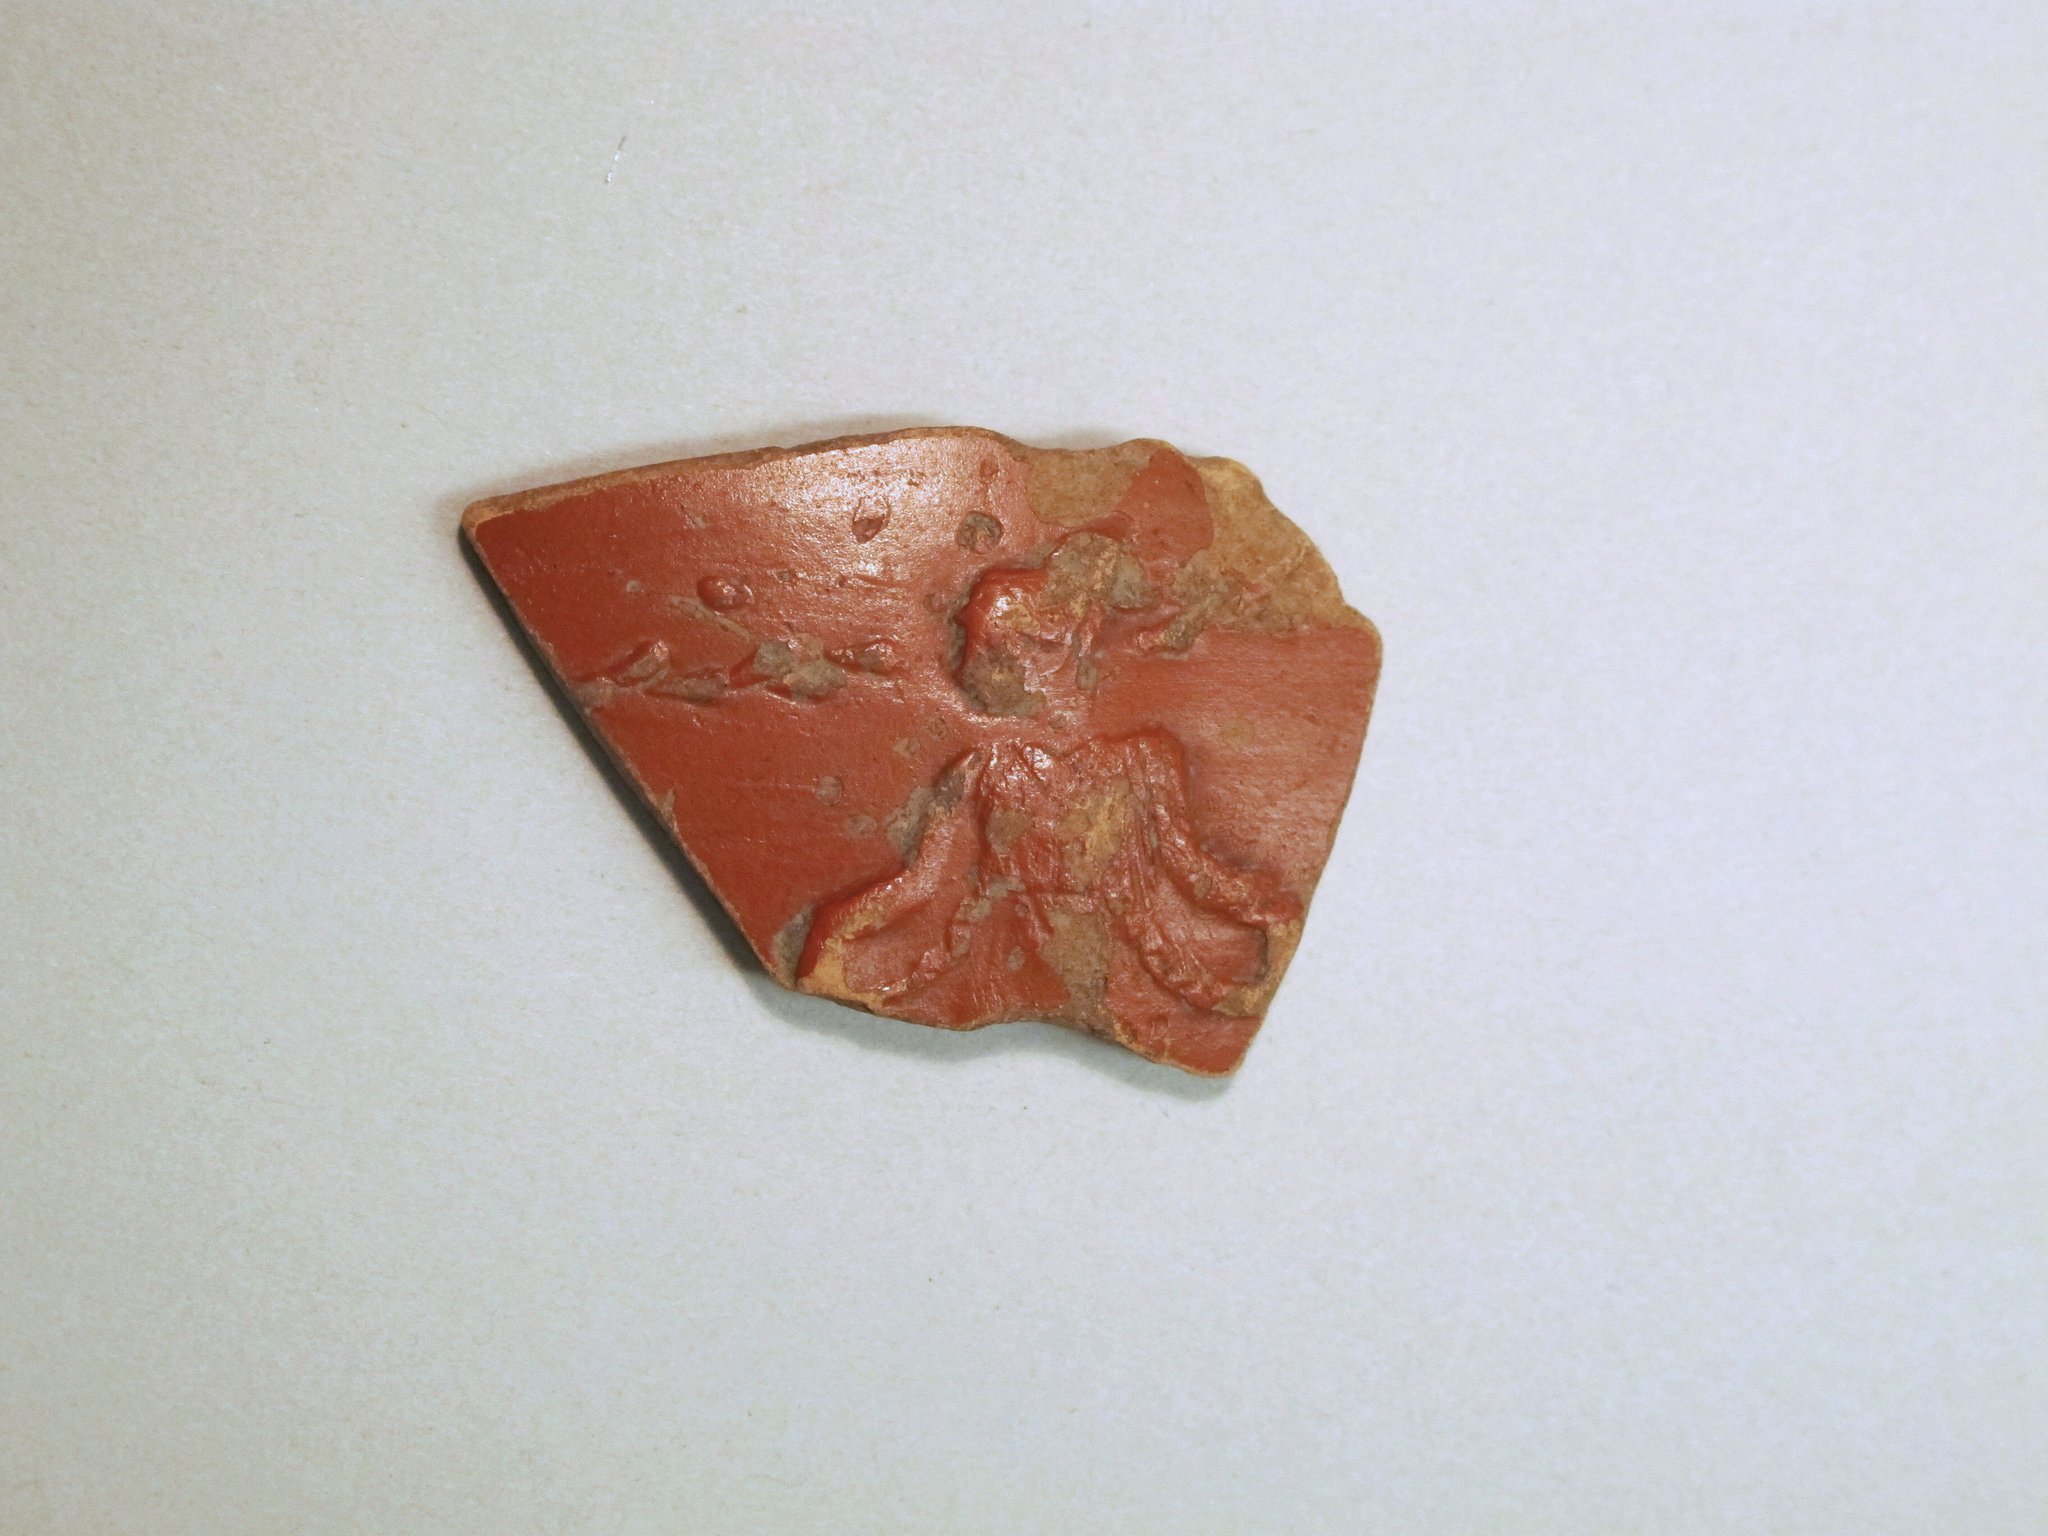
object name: vase fragment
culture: roman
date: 100 BCE-100 CE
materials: terracotta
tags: women,dancers